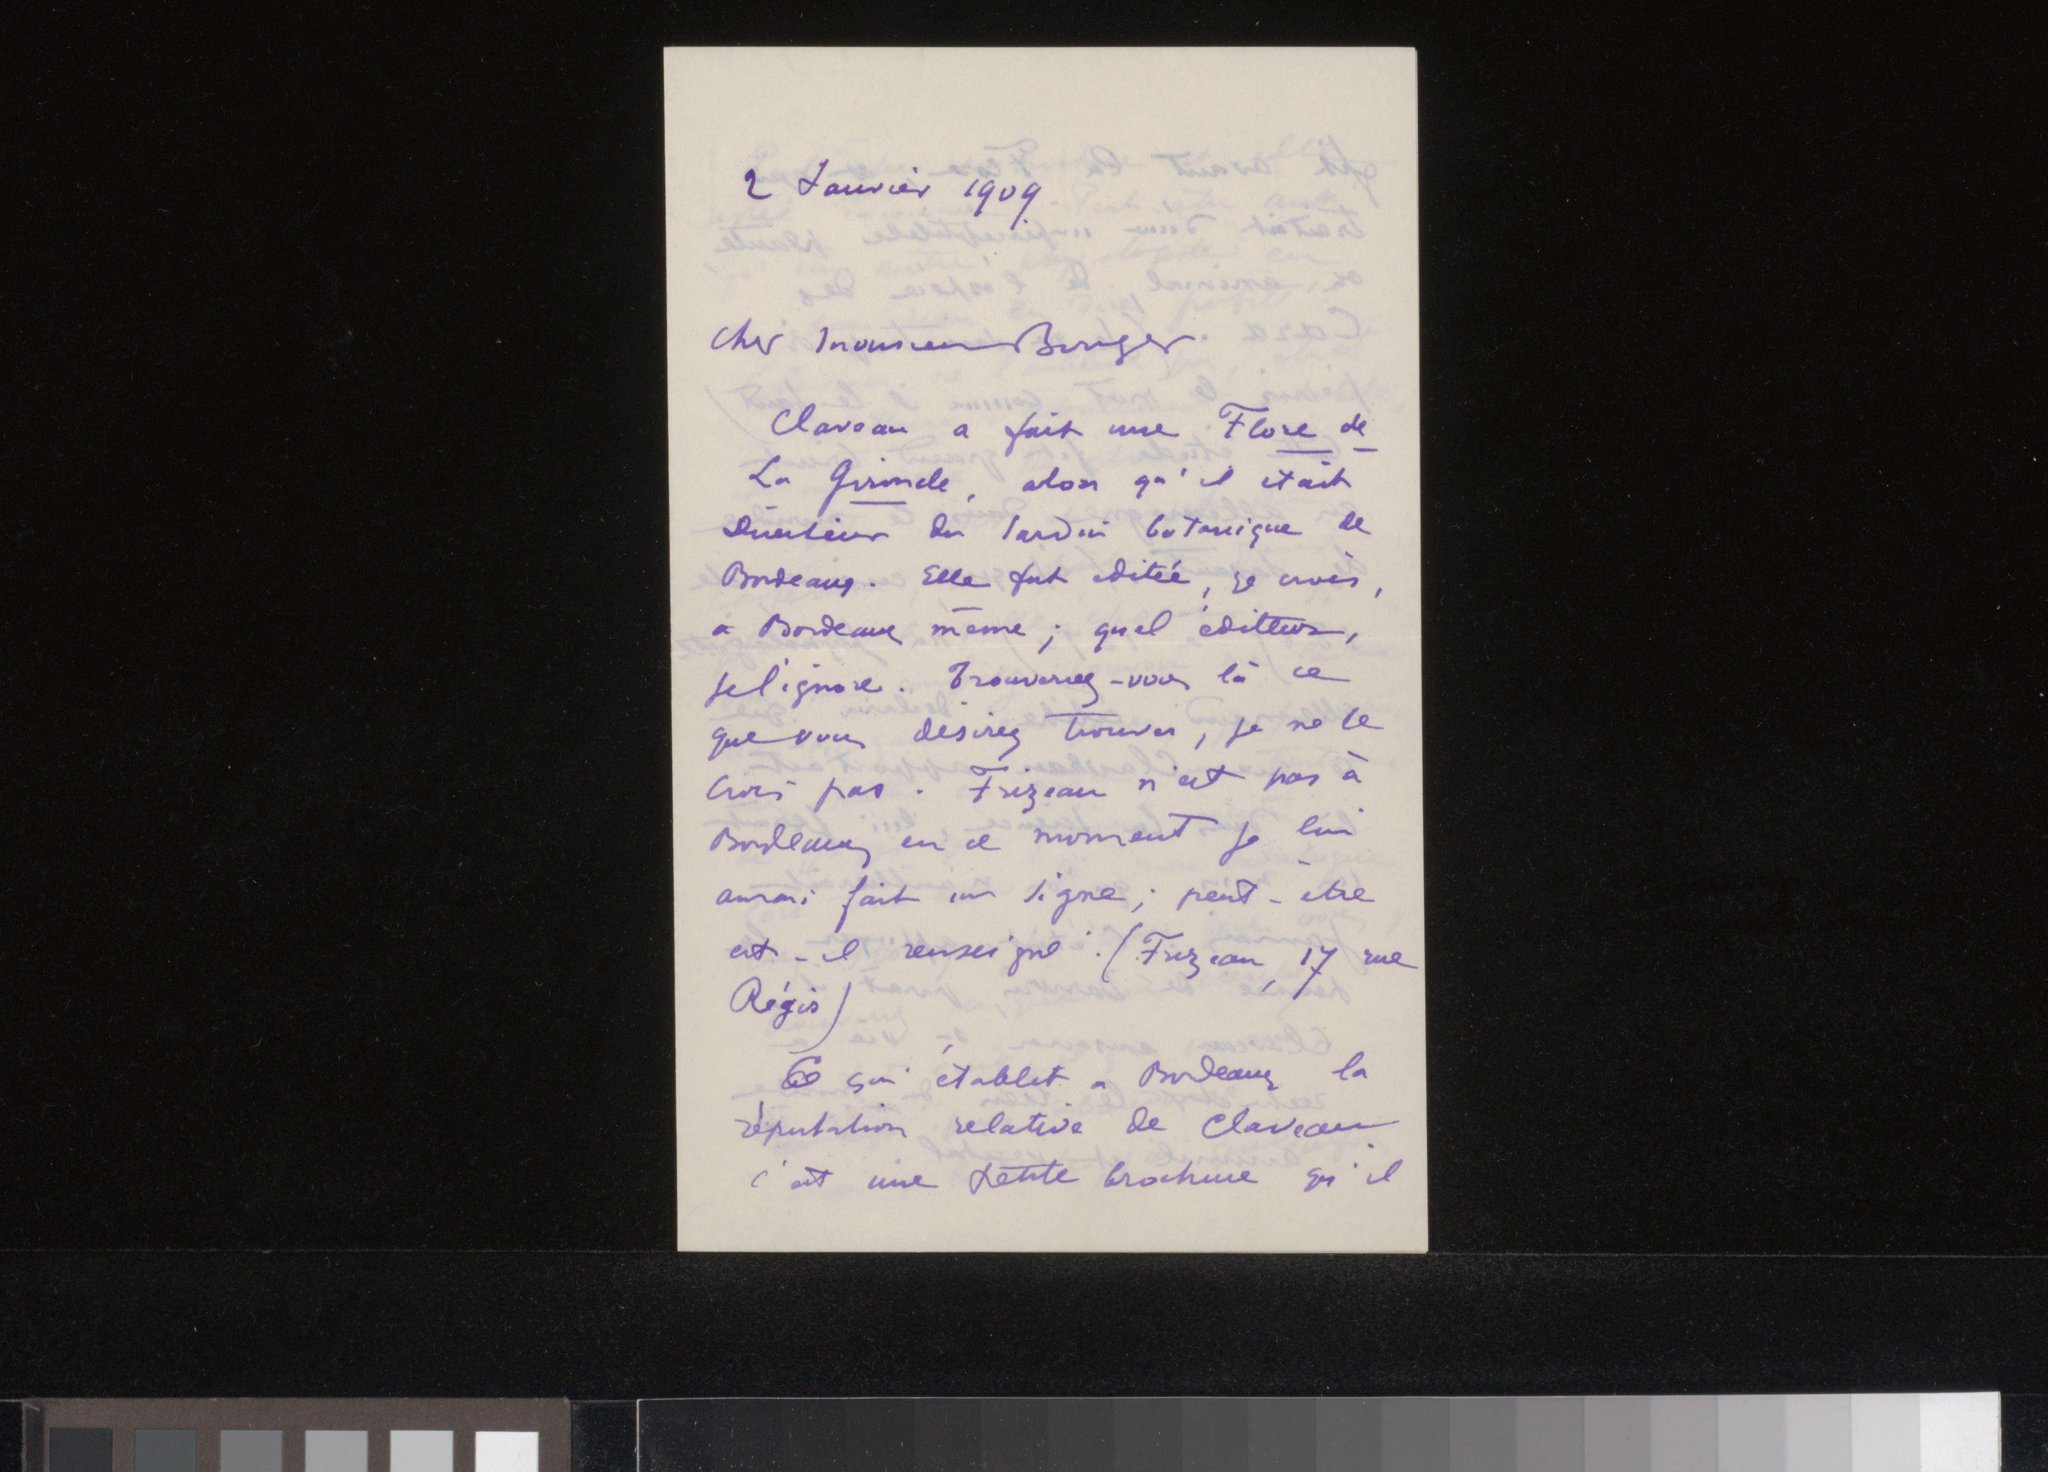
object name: letter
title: Brief aan Andries Bonger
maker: odilon redon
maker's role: draughtsman, painter, print maker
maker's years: 1840-1916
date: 1909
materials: ink, paper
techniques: pen, writing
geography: paris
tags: armand clavaud, sculptor, edgar degas, amsterdam, andries bonger, edgar allan poe, charles darwin, passions, emotions, affections, exhibition ~ art, printed matter, germany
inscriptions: watermark